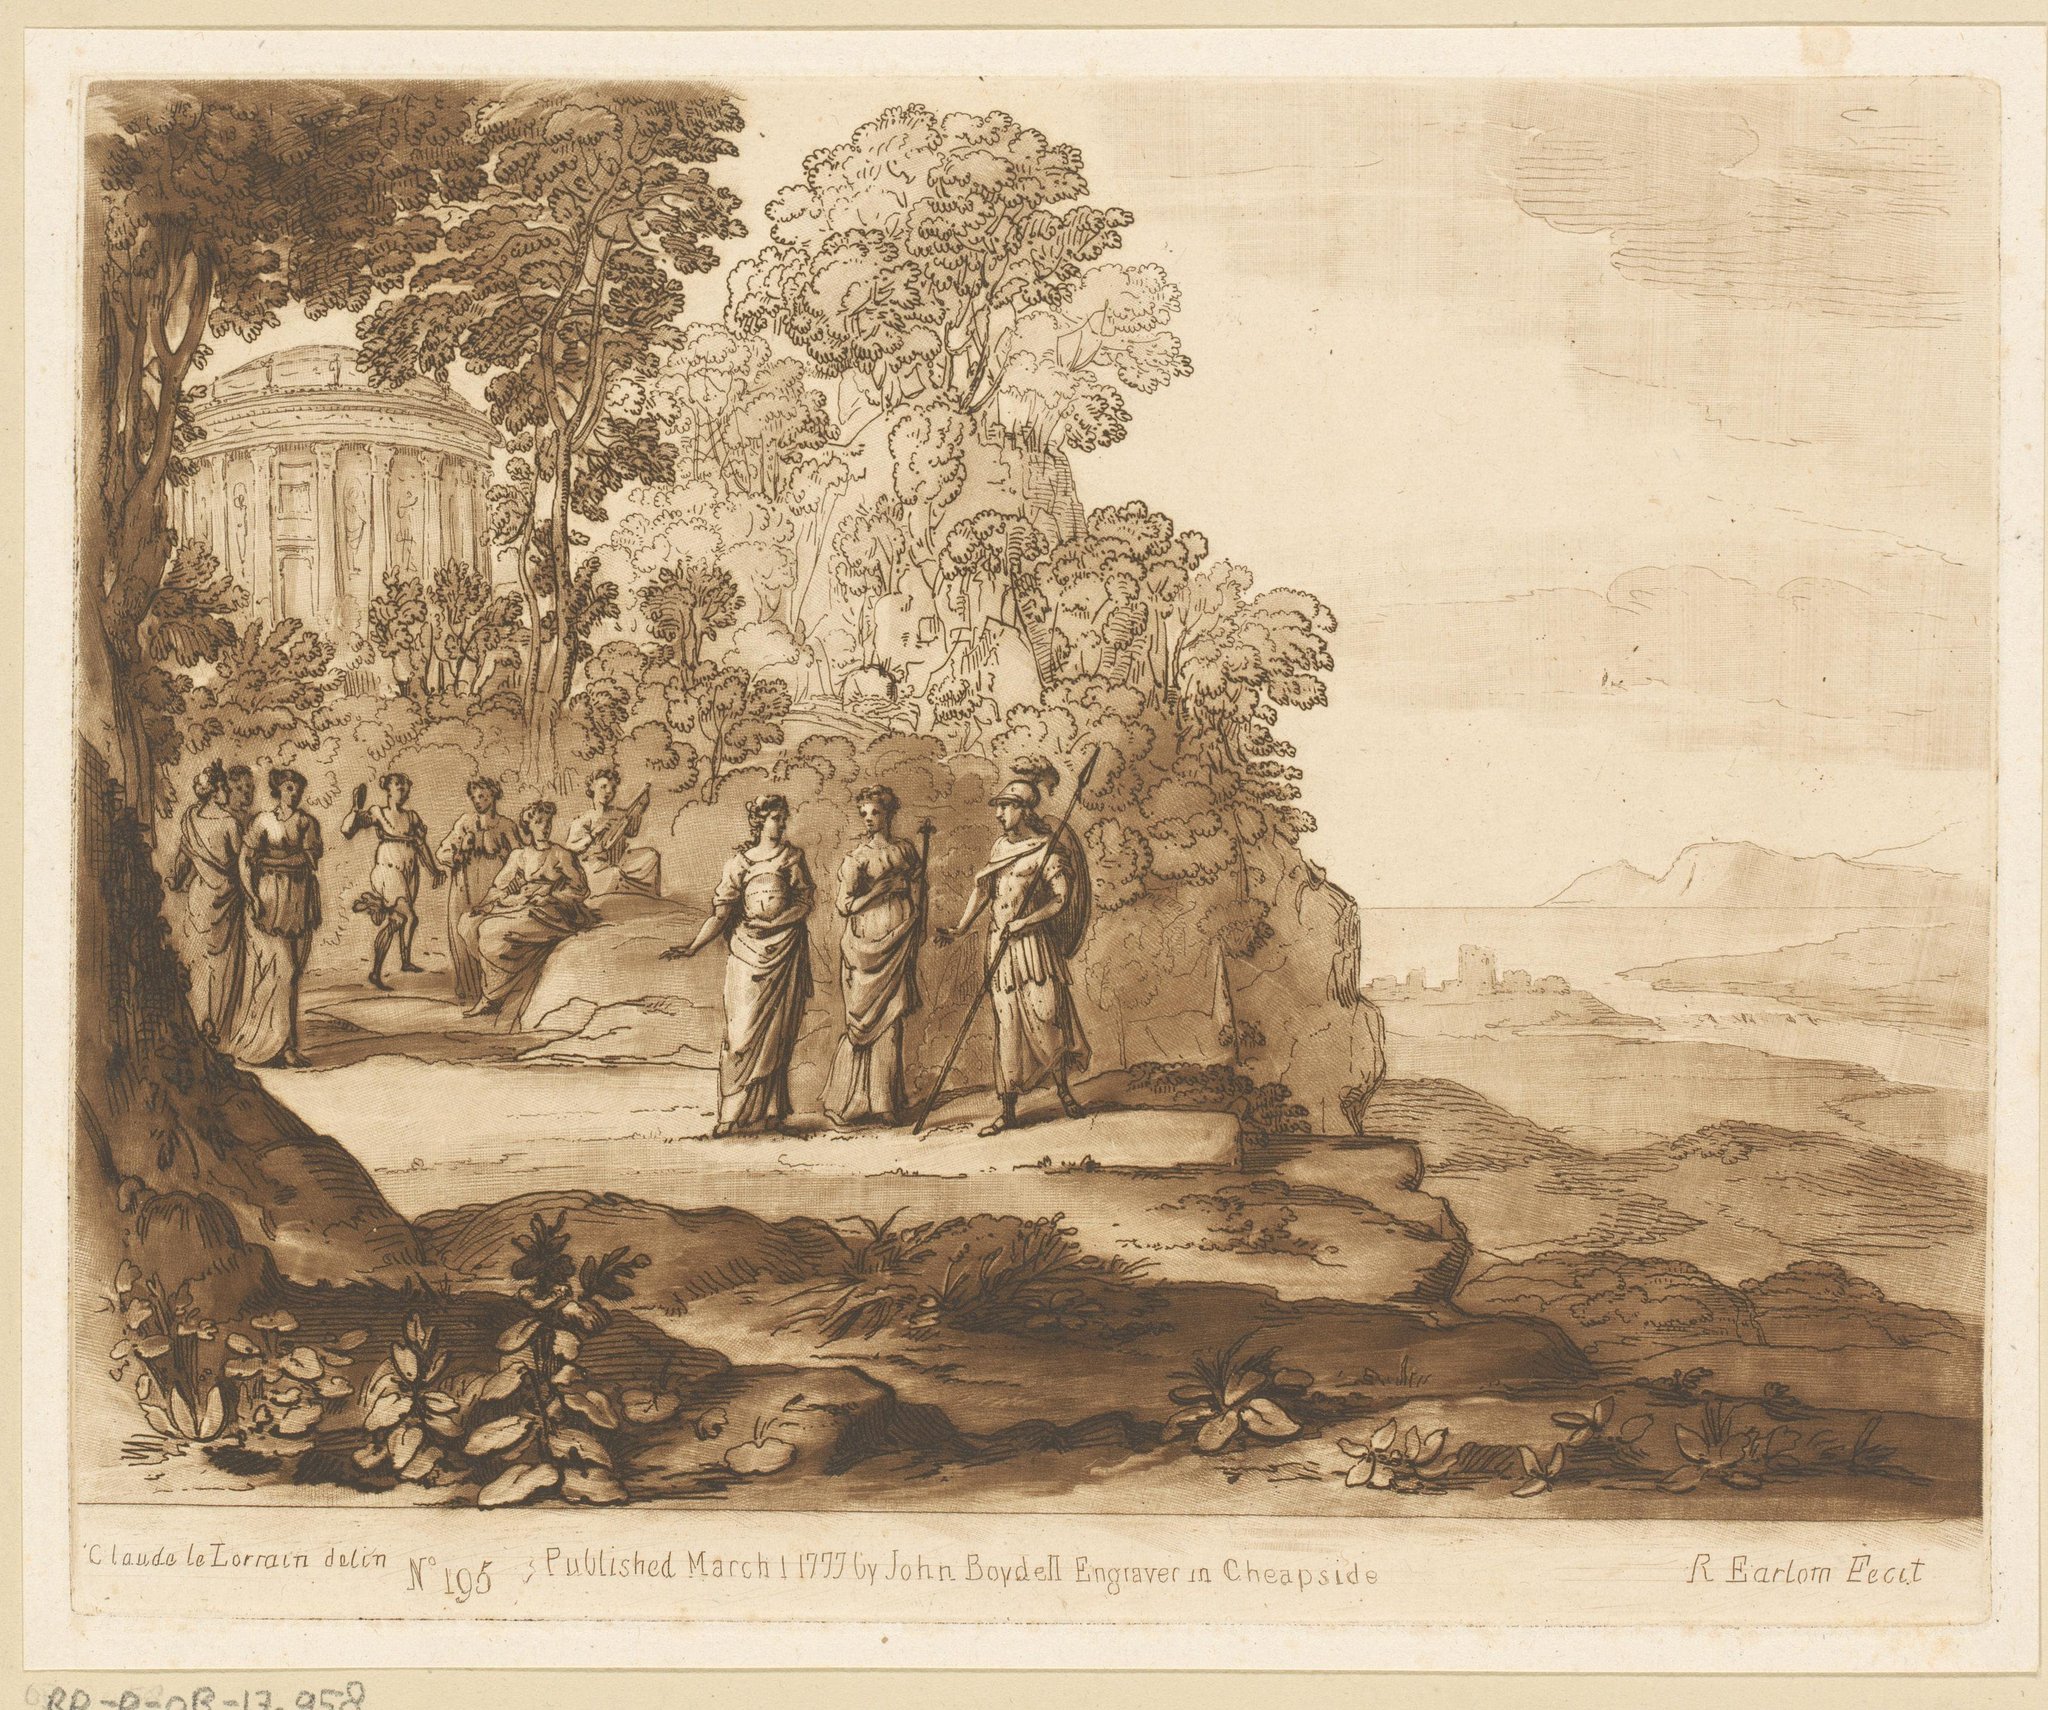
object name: print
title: Prenten naar tekeningen van Claude Lorrain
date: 1777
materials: paper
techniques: etching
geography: london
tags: temple, shrine ~ roman religion, helicon, sacred to the muses, minerva visits the muses on mount helicon to see the fountain hippocrene, which pegasus had just brought forth, mountains - hh - ideal landscapes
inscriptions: date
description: Vanaf 1774 publiceerde John Boydell tweehonderd prenten naar het tekeningenboek Liber Veritatis van Claude Lorrain, in het bezit van de hertogen van Cavendish. Deze prenten werden vanaf 1777 in twee volumes gebundeld uitgegeven.